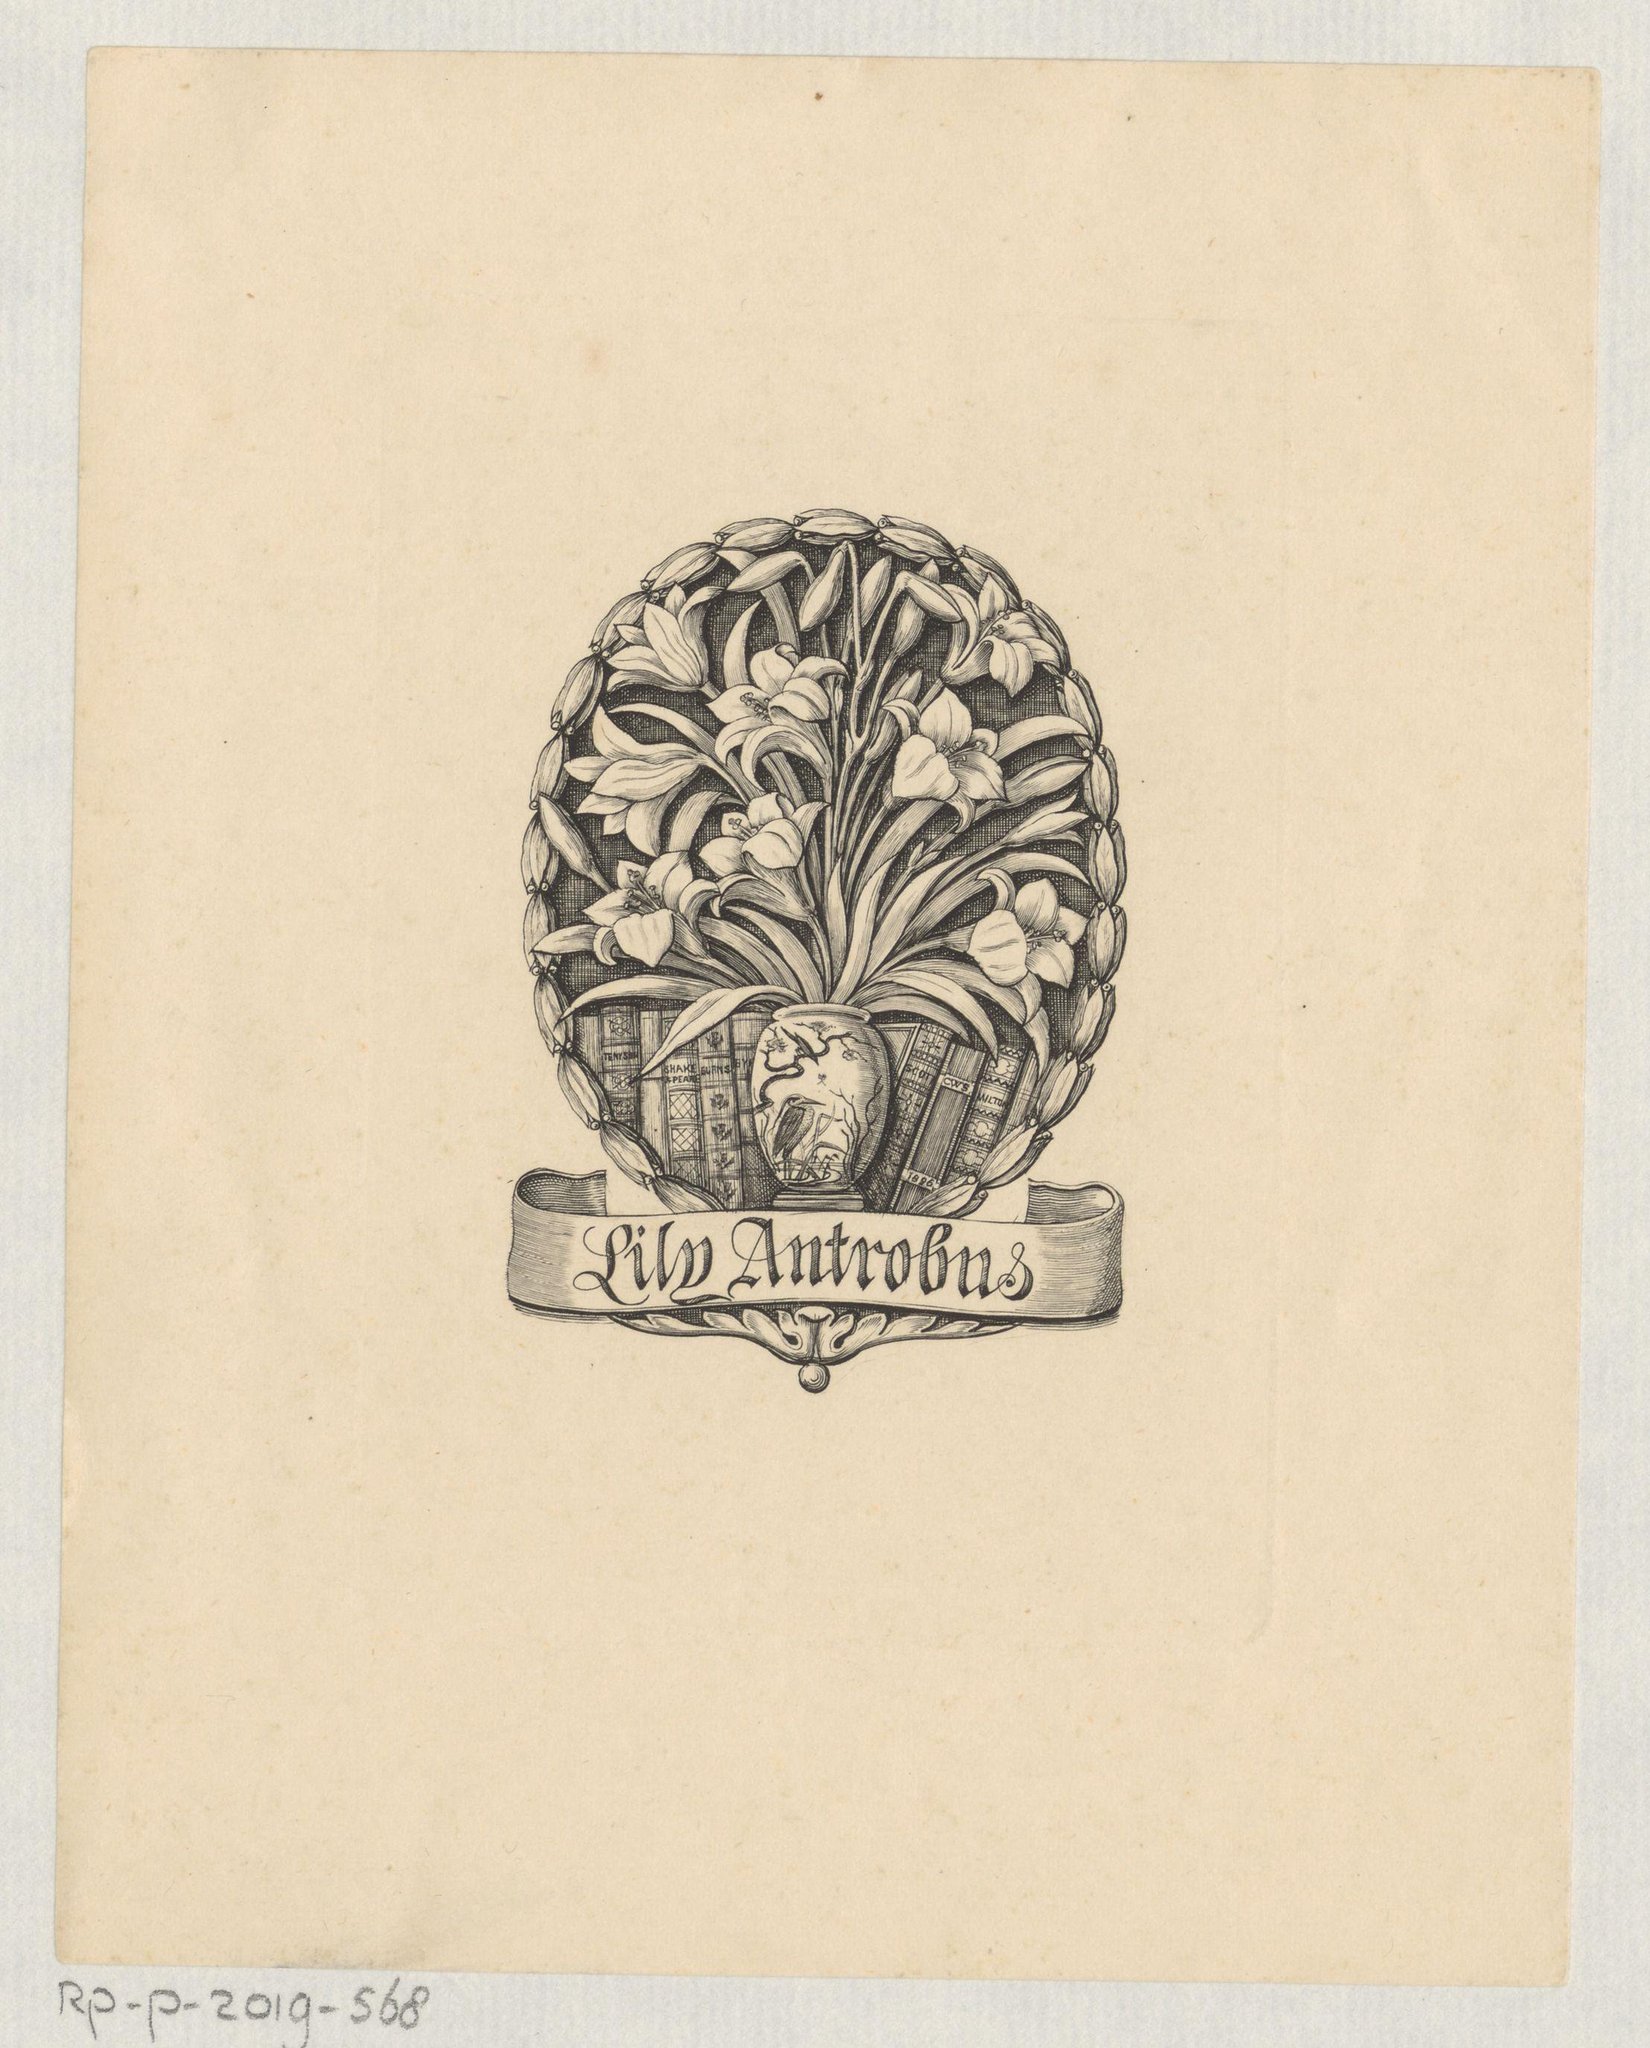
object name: bookplate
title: Ex libris van Lily Antrobus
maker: charles william sherborn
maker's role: print maker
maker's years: 1831-1912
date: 1841-1912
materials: paper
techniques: engraving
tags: book, flowers: lily